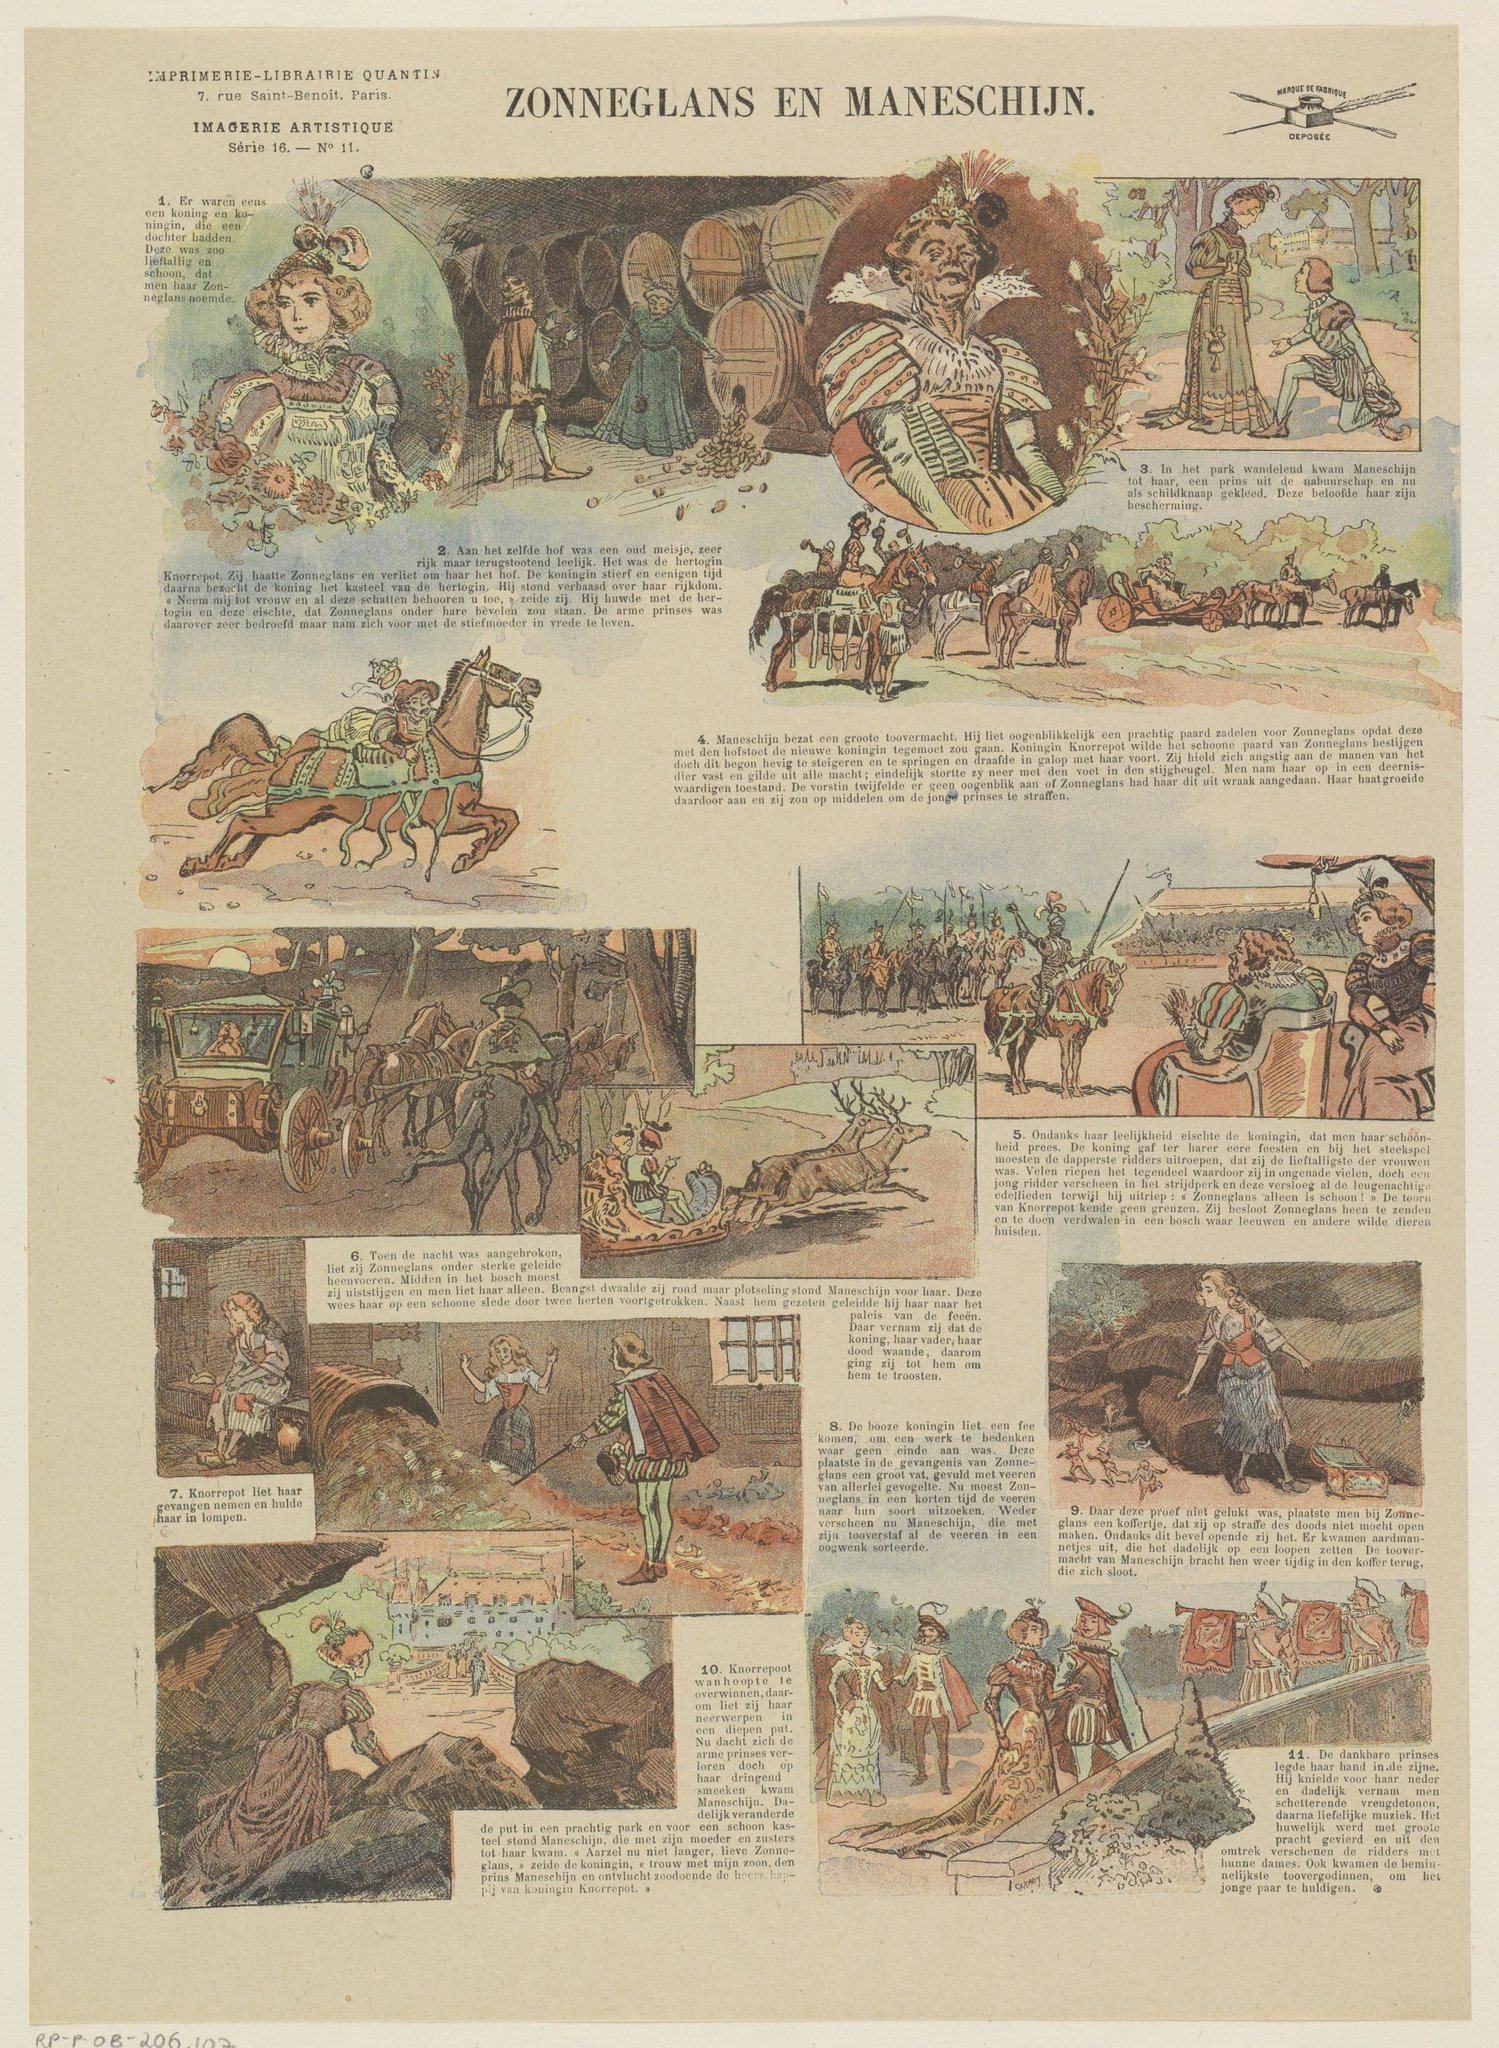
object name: print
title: Zonneglans en Maneschijn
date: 1876-1890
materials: paper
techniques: lithograph, letterpress printing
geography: paris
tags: prince, princess, tales and fairy tales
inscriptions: collector's mark: Lugt 2760, : ‘marque de fabrique / deposée’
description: Blad met 14 voorstellingen uit het sprookje van prinses Zonneglans, prins Maneschijn en hun boze stiefmoeder. Onder elke afbeelding een onderschrift. Genummerd linksboven: Série 16. - No. 11.